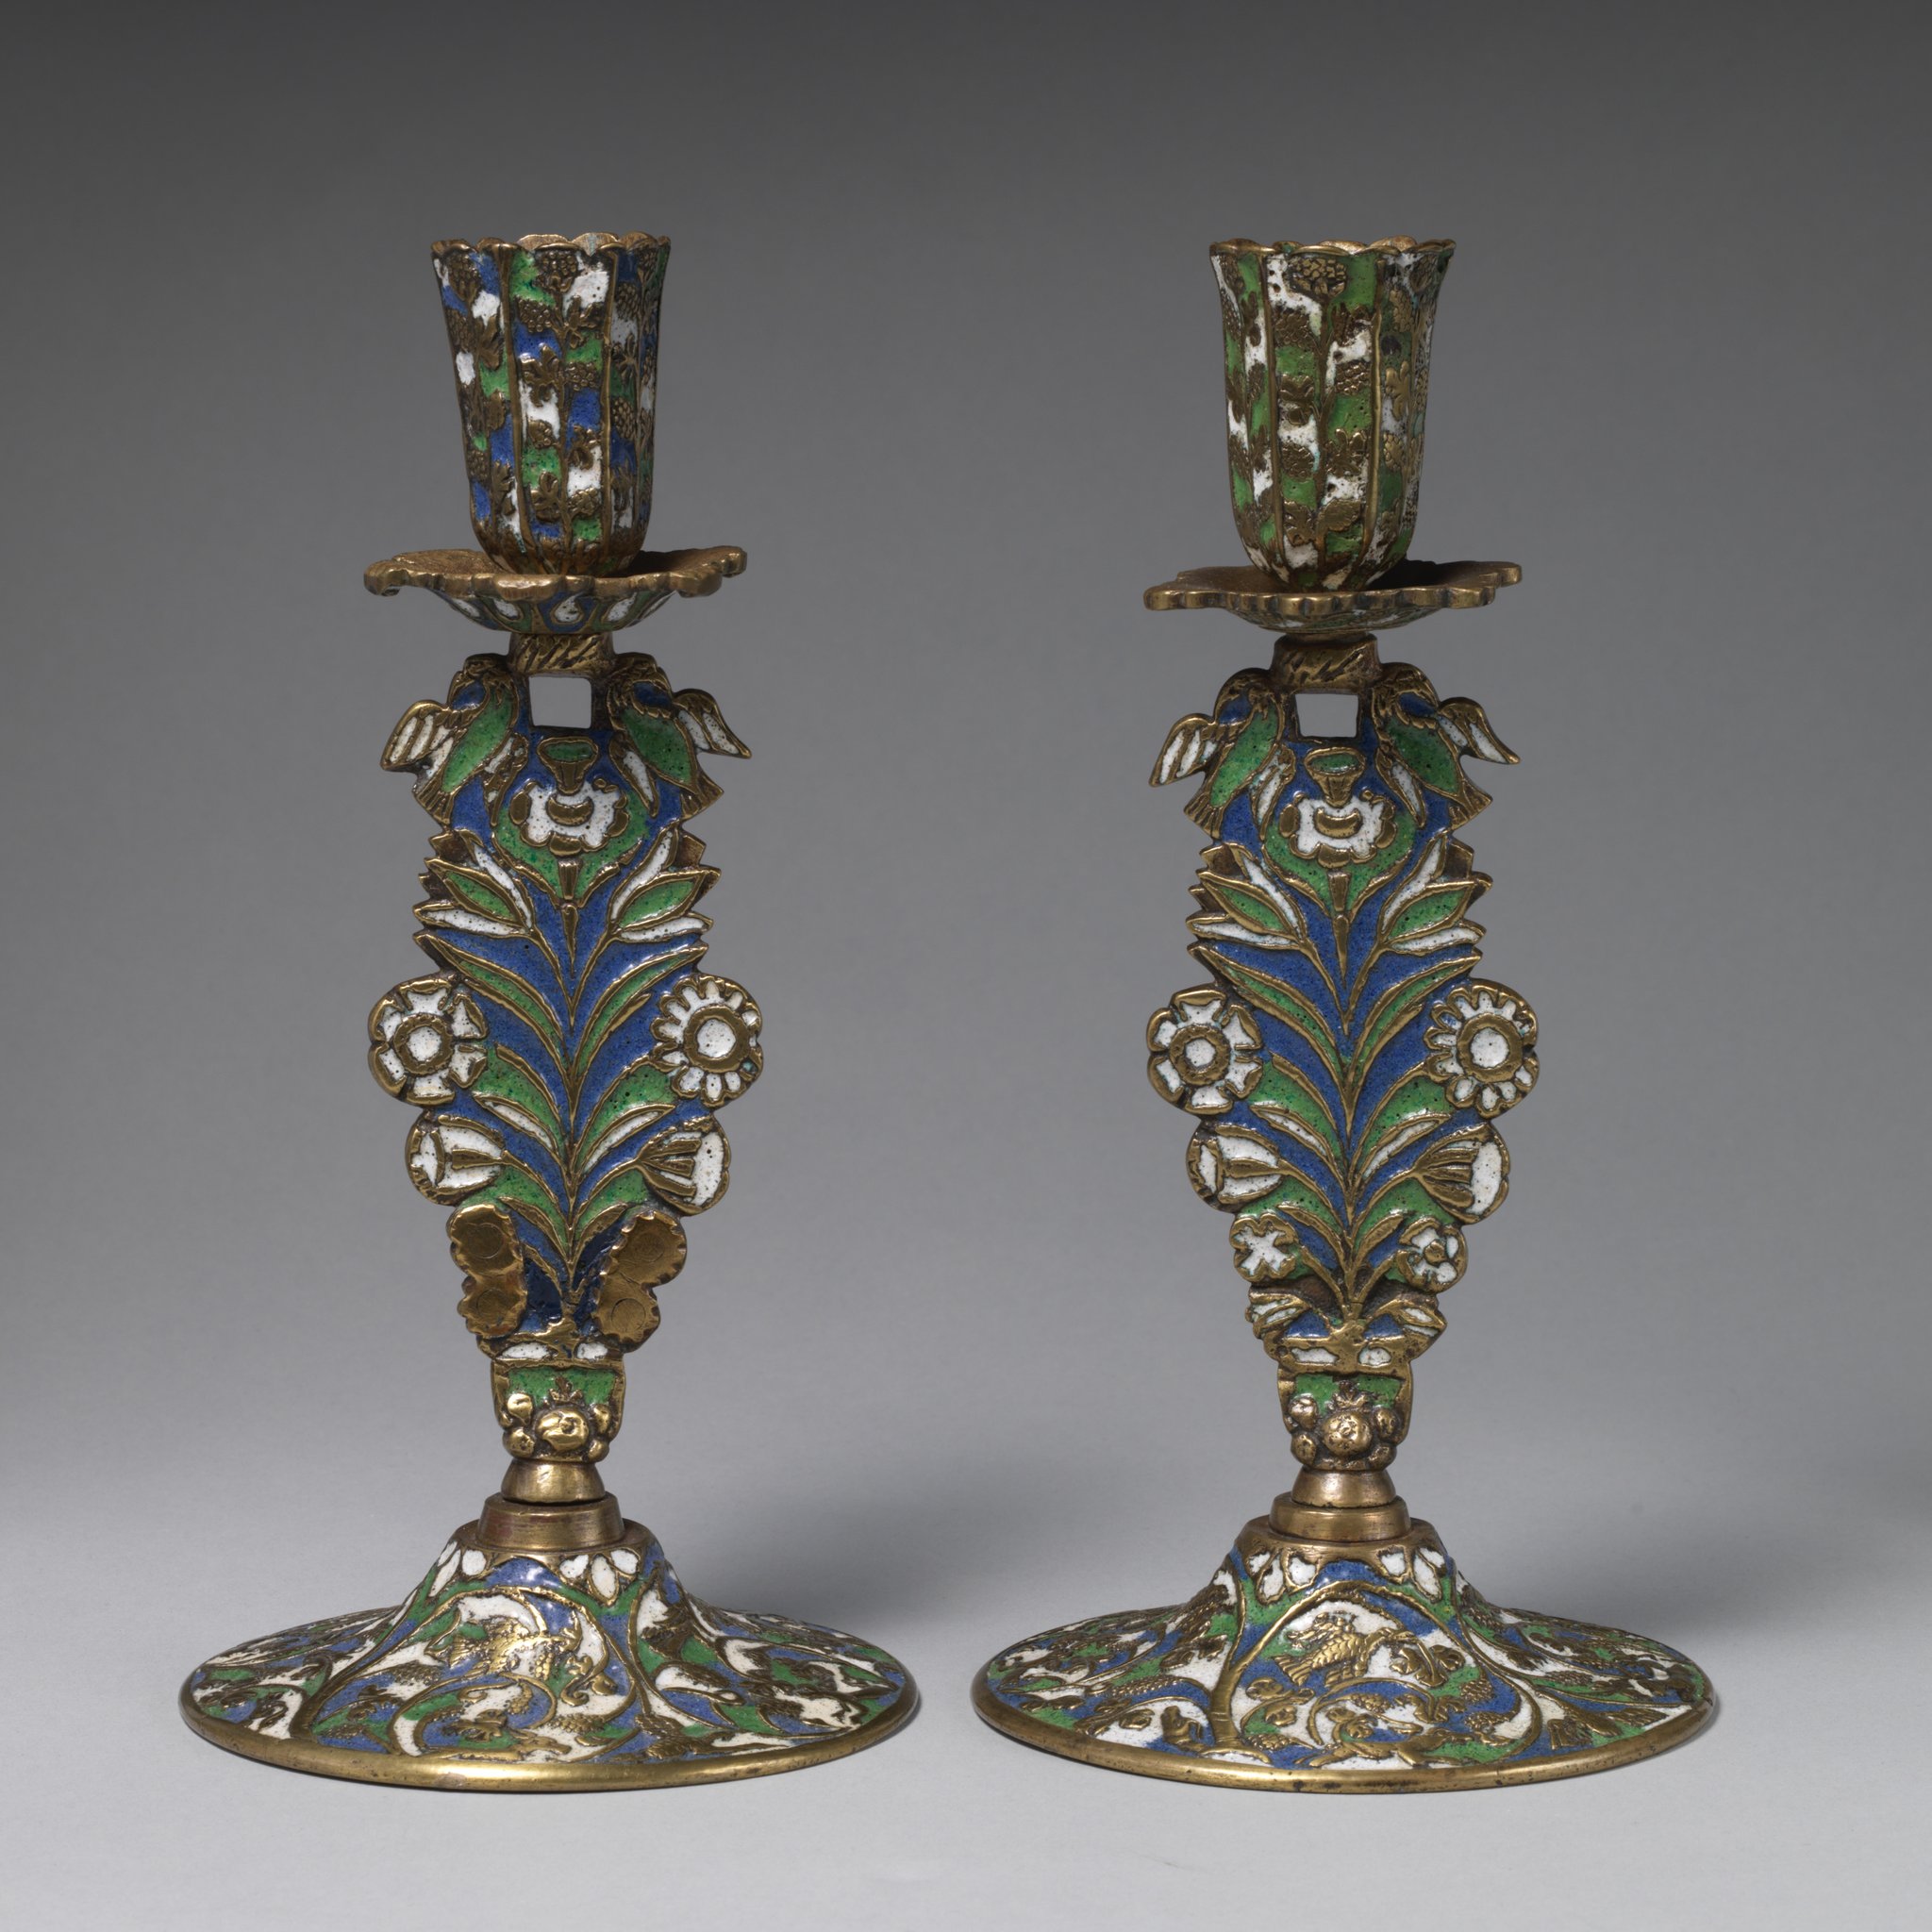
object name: candlestick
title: Candlestick (one of a pair)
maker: stephen pilcherd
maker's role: maker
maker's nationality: british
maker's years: 1570-1670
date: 1660-1680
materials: brass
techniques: enamel